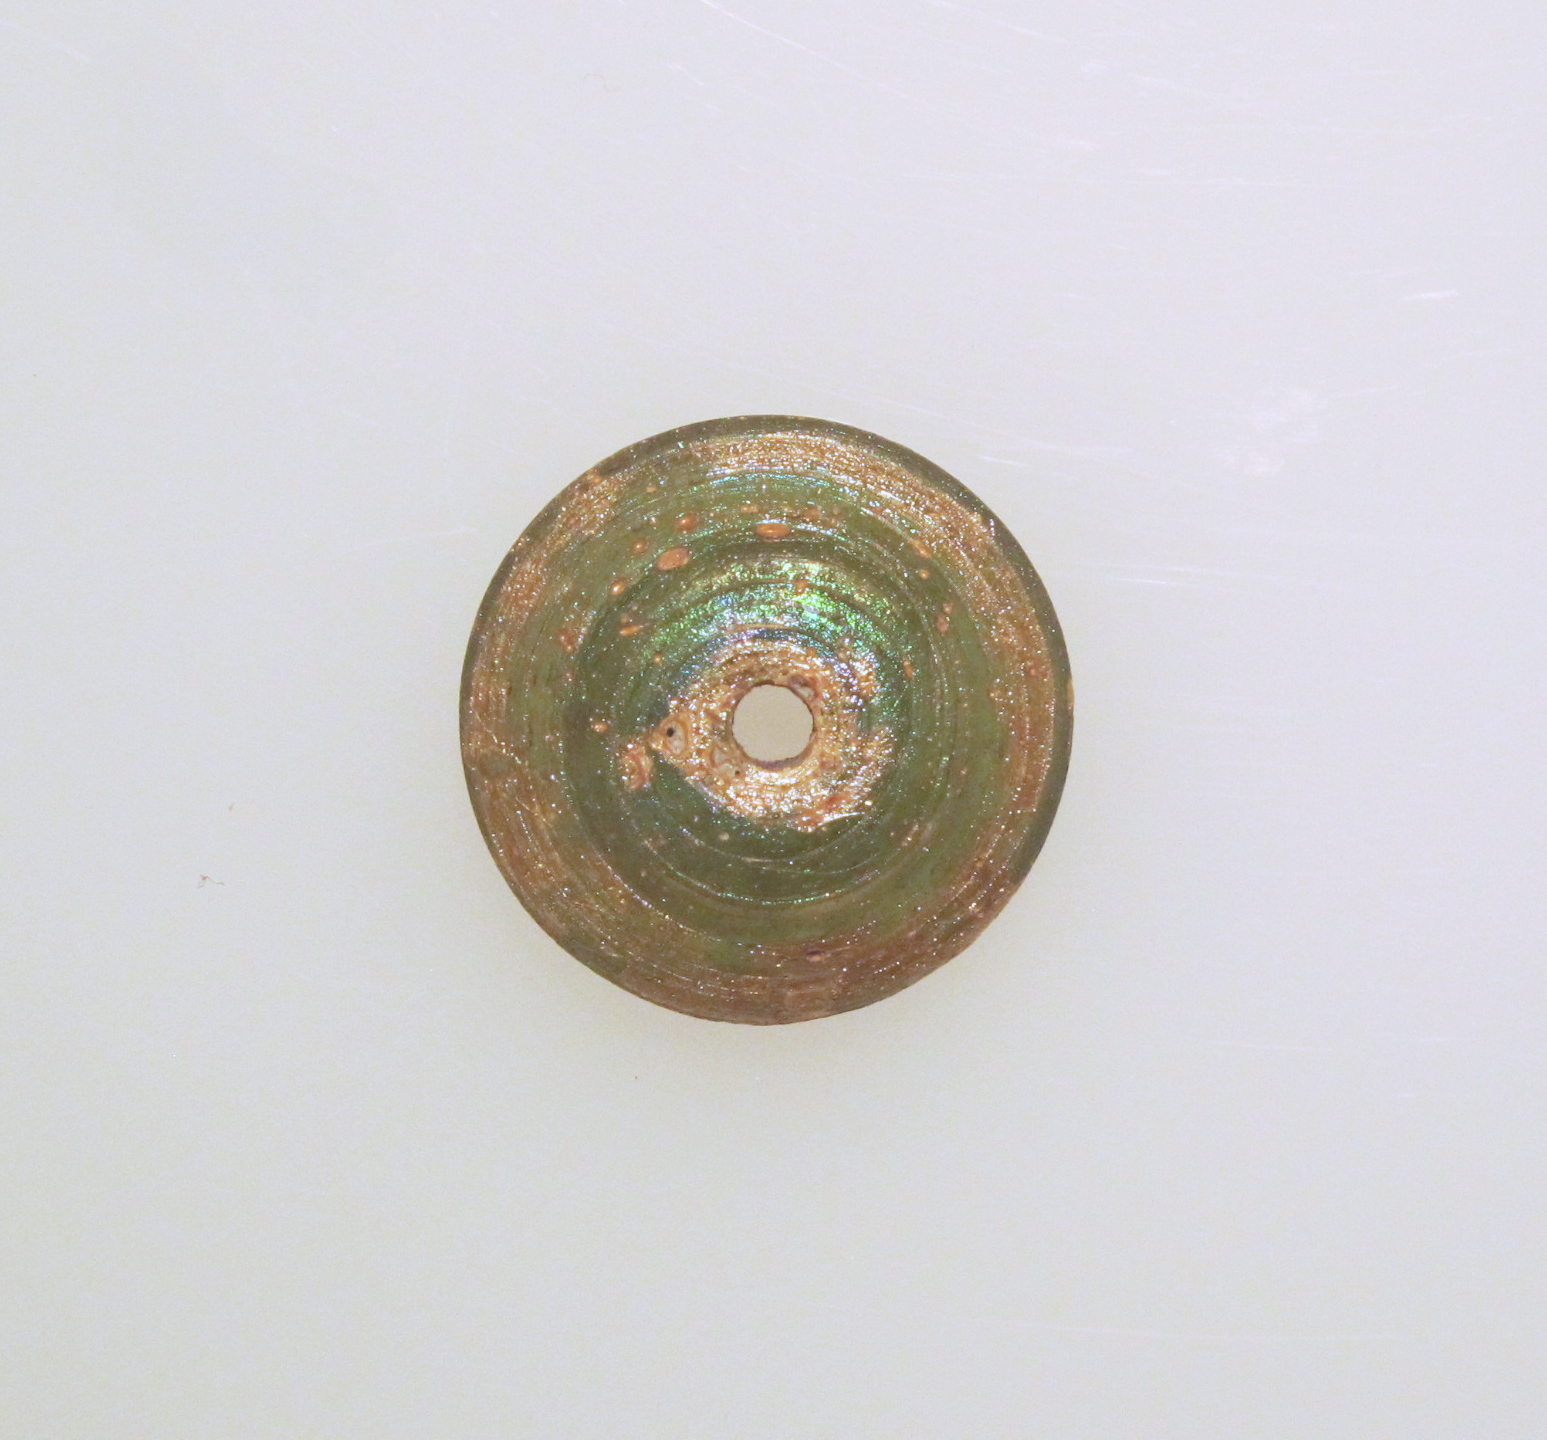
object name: spindle whorl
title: Glass spindle whorl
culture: roman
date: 1-200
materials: glass